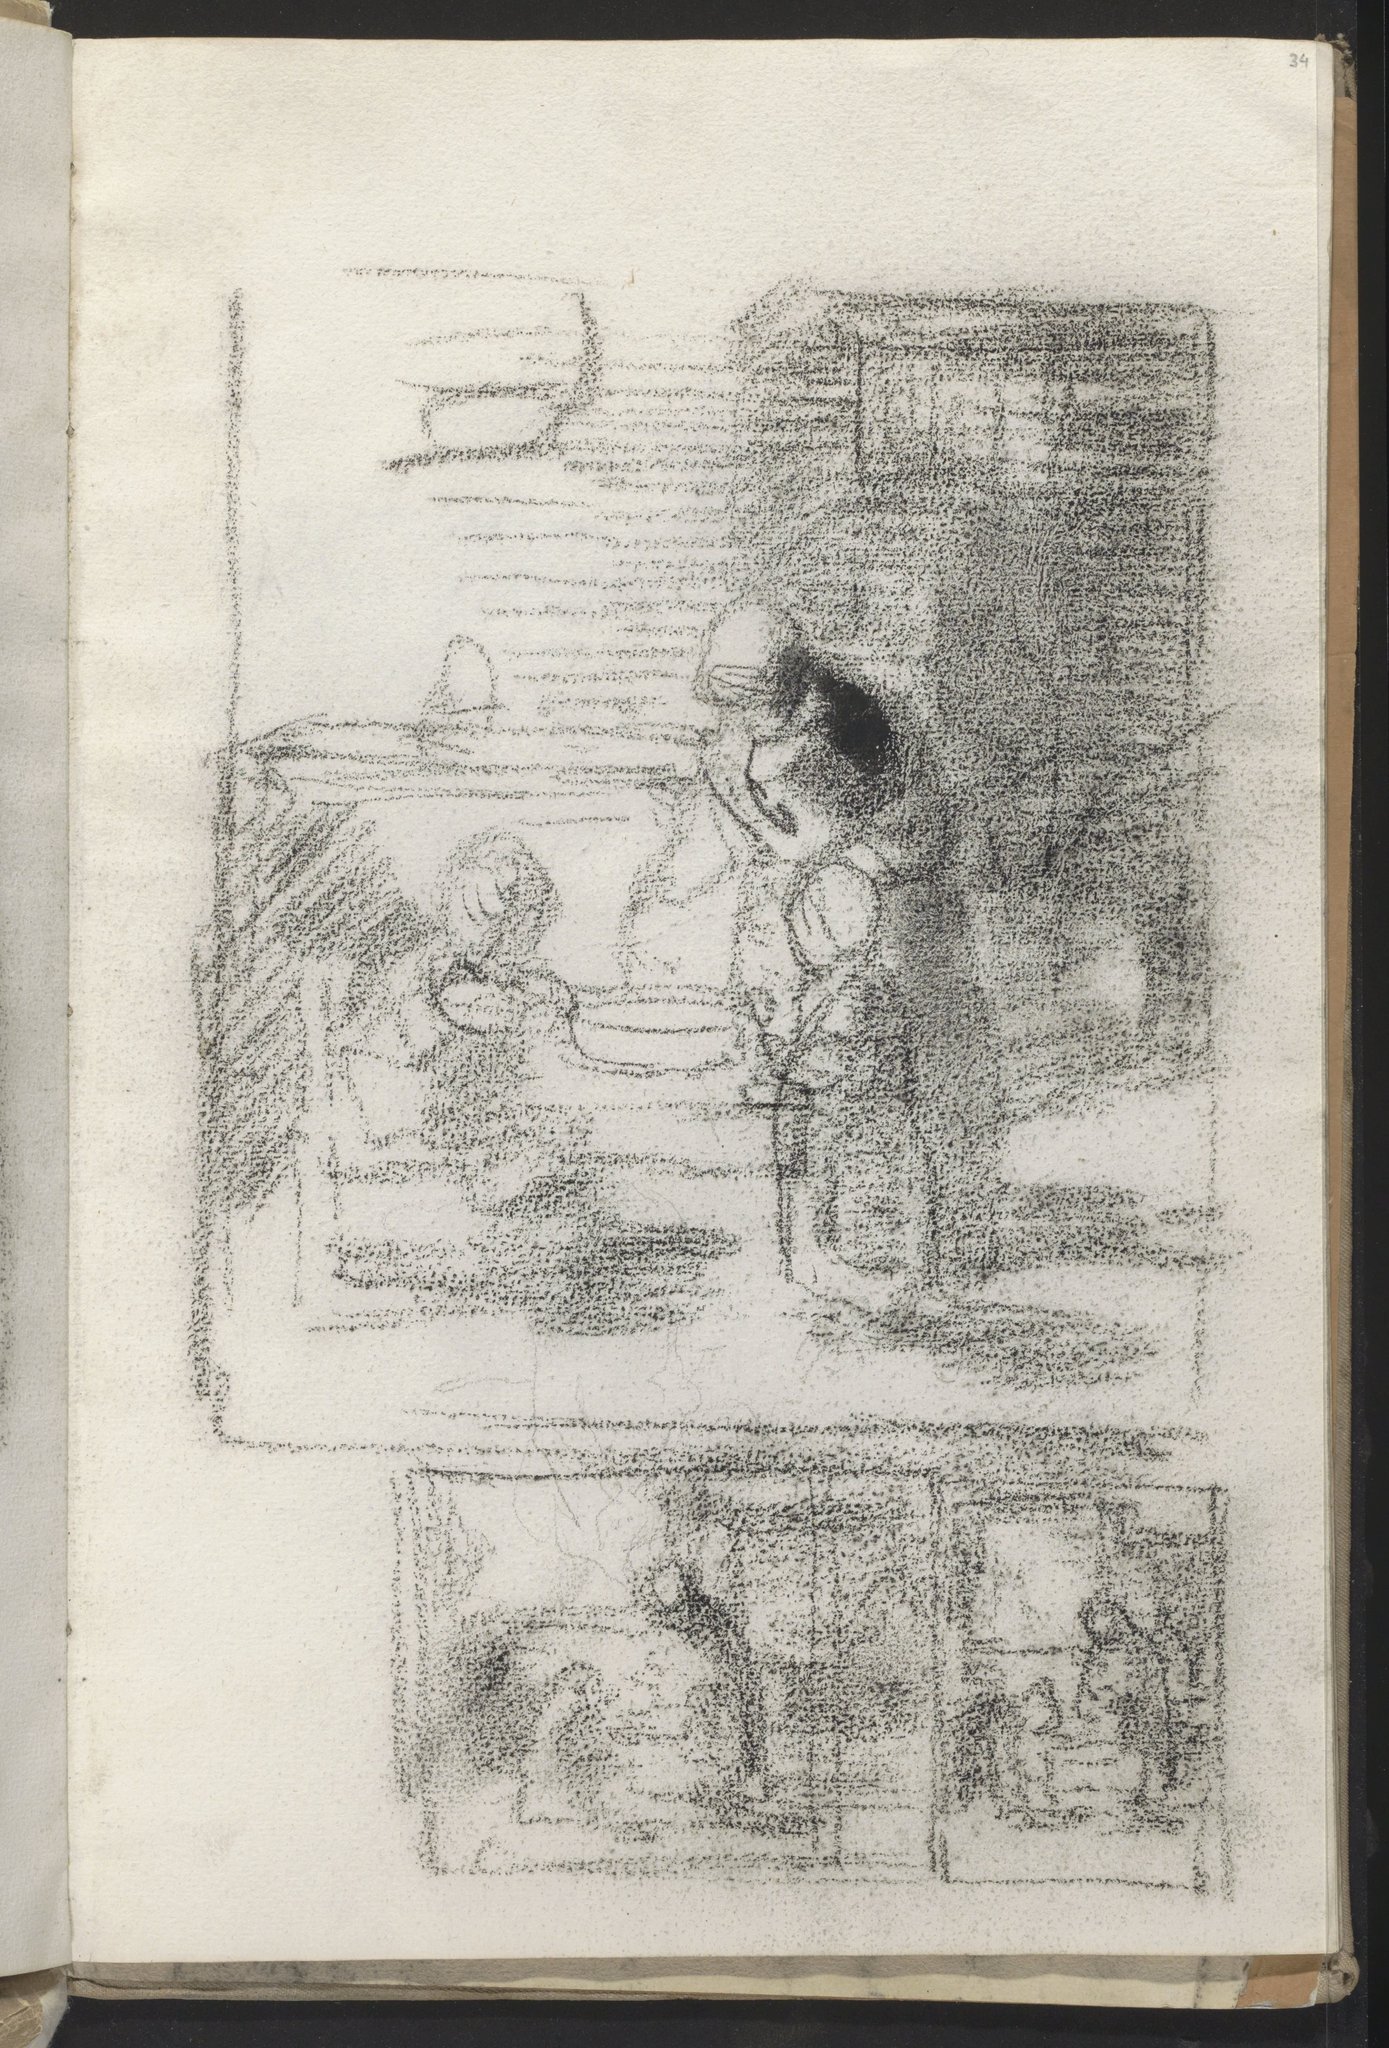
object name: sketchbook leaf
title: Interieur met een moeder die een maaltijd serveert aan haar twee kinderen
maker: albert neuhuys (1844-1914)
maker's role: draughtsman, painter, print maker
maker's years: 1844-1914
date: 1854-1914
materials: chalk, paper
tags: table, interior of the house, mother and child(ren), woman and child(ren) (family group), (family) meal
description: De twee jonge kinderen zitten aan een lage tafel waarop een grote pan staat. Blad 34 recto uit een schetsboek met 53 bladen.